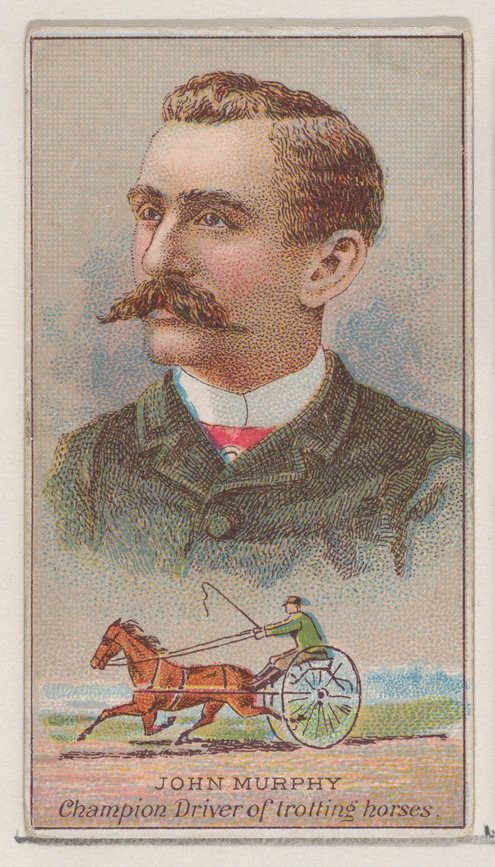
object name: print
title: John Murphy, Champion Driver of Trolling Horses, from the Champions of Games and Sports series (N184, Type 2) issued by W.S. Kimball & Co.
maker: w.s. kimball & co.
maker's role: publisher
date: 1887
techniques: color lithograph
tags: men,horses,athletes